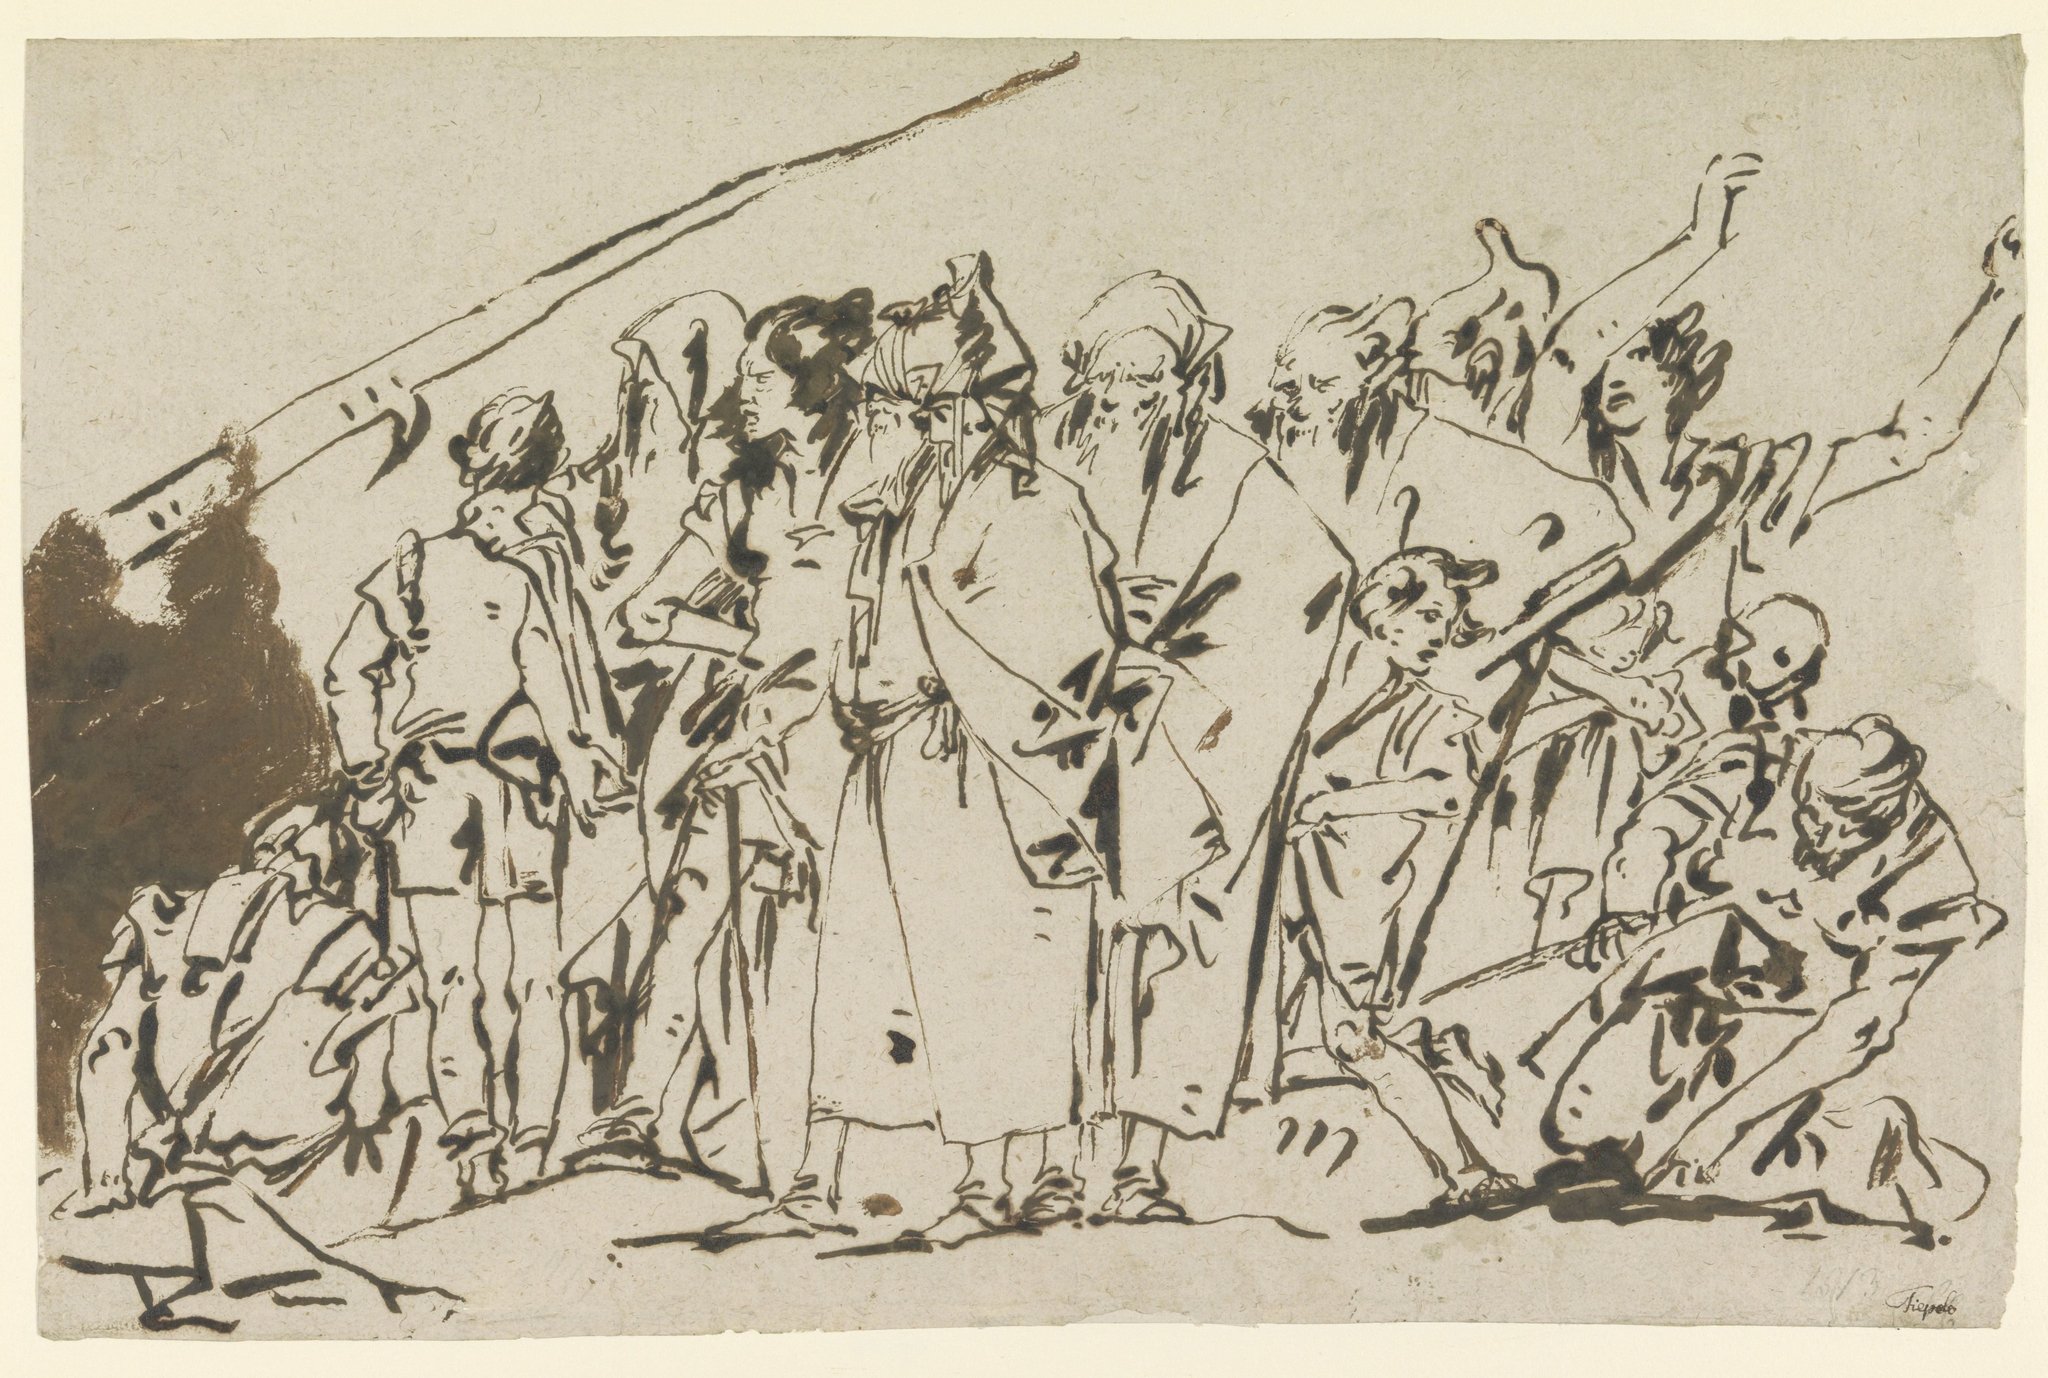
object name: drawing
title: Groep Oosterlingen, soldaten en vrouwen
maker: giovanni domenico tiepolo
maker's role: draughtsman, print maker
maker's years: 1727-1804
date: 1737-1804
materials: ink, paper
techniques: brush, pen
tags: asiatic races and peoples